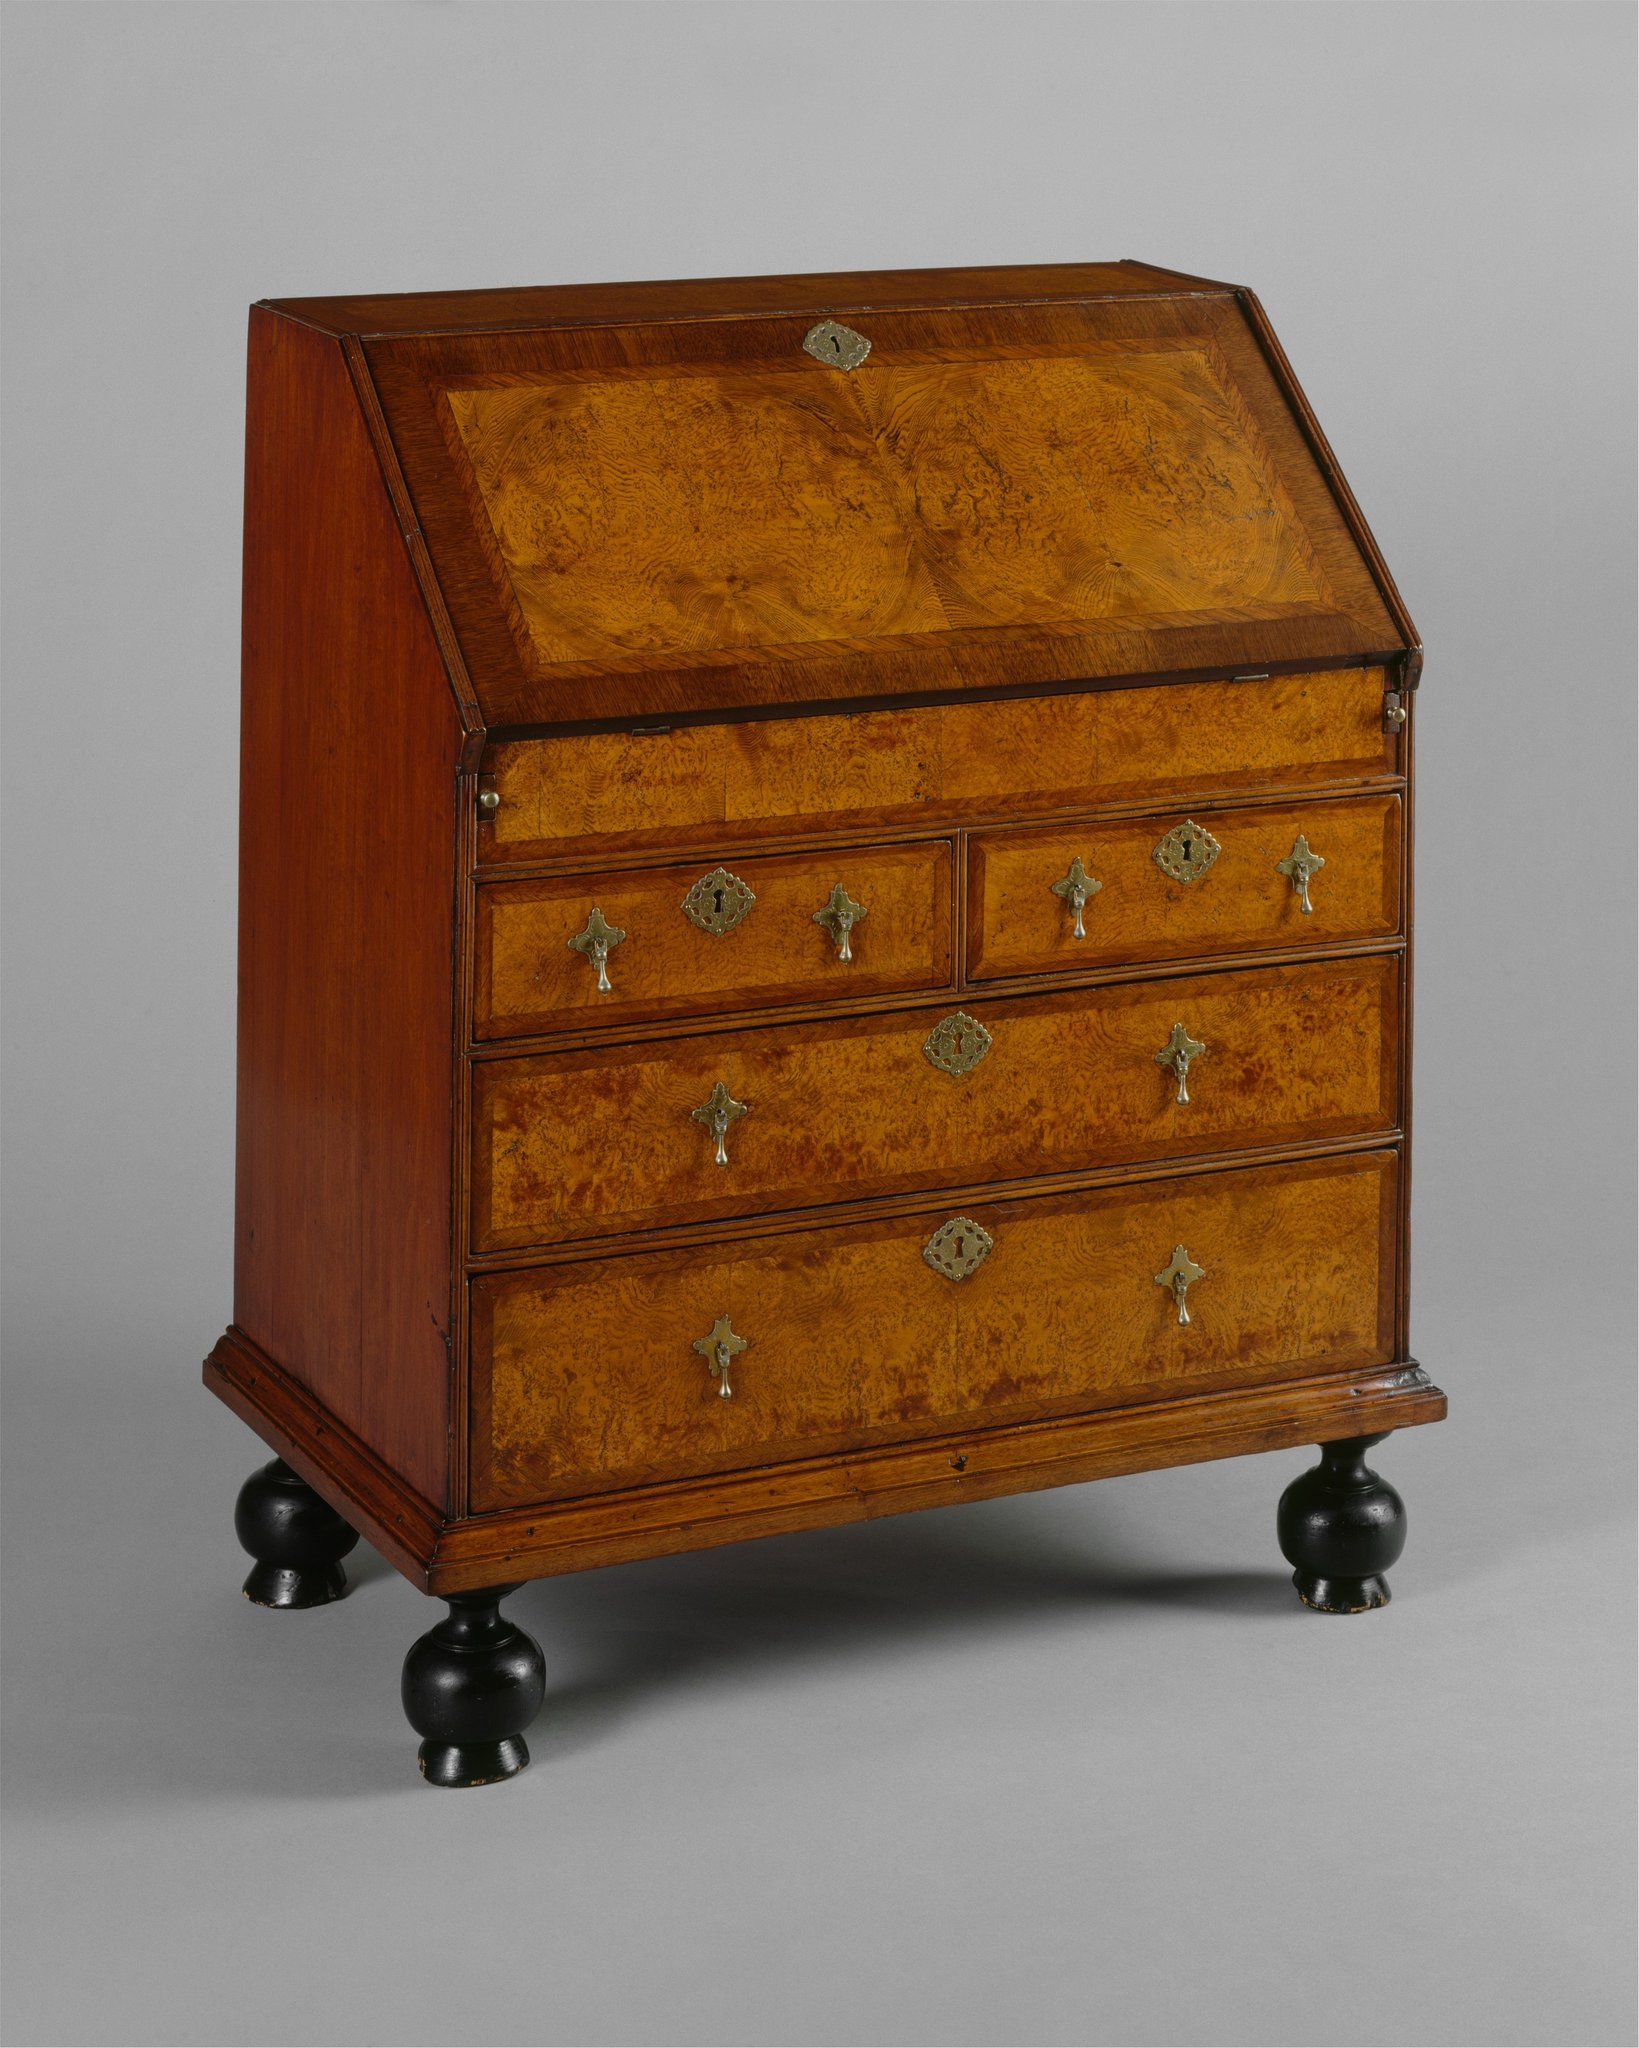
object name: desk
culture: american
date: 1700-1730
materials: wood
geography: united states